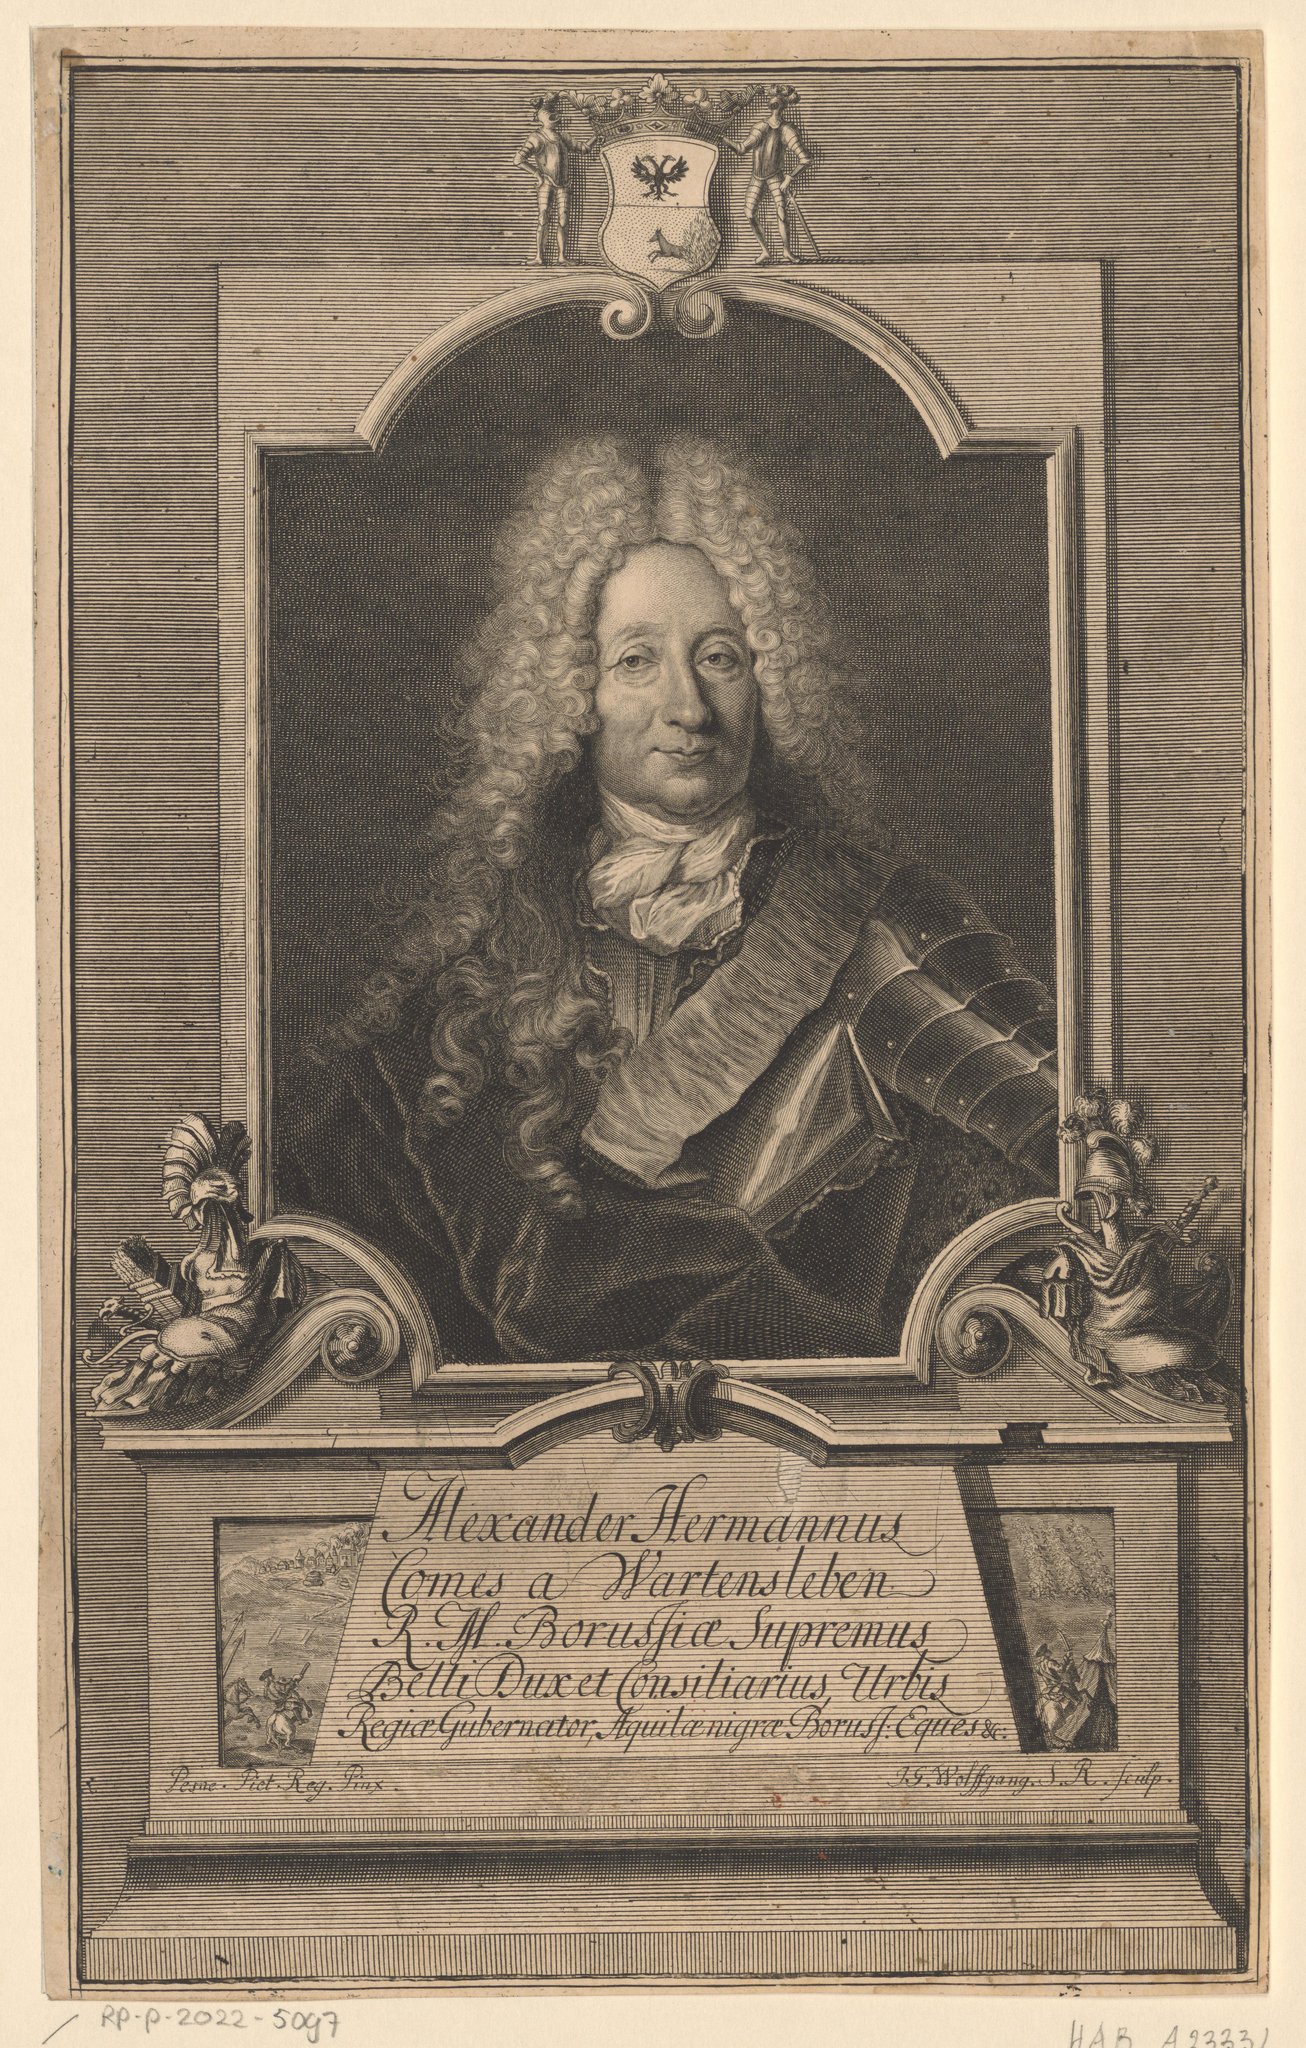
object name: print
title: Portret van Alexander Hermann von Wartensleben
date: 1718-1720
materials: paper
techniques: engraving, etching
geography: germany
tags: berlin, earl, charge ~ battle (+ cavalry, horsemen), commander-in-chief, general, marshal, armour, historical persons, armorial bearing, heraldry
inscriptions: inscription: ‘RNJV’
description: Prent waarschijnlijk uit: Theatrum Europaeum (...). Frankfurt: Carl Gustav, erven Matthäus Merian, 1718, dl. 17. Komt mogelijk ook voor in de tweede druk uit 1720.